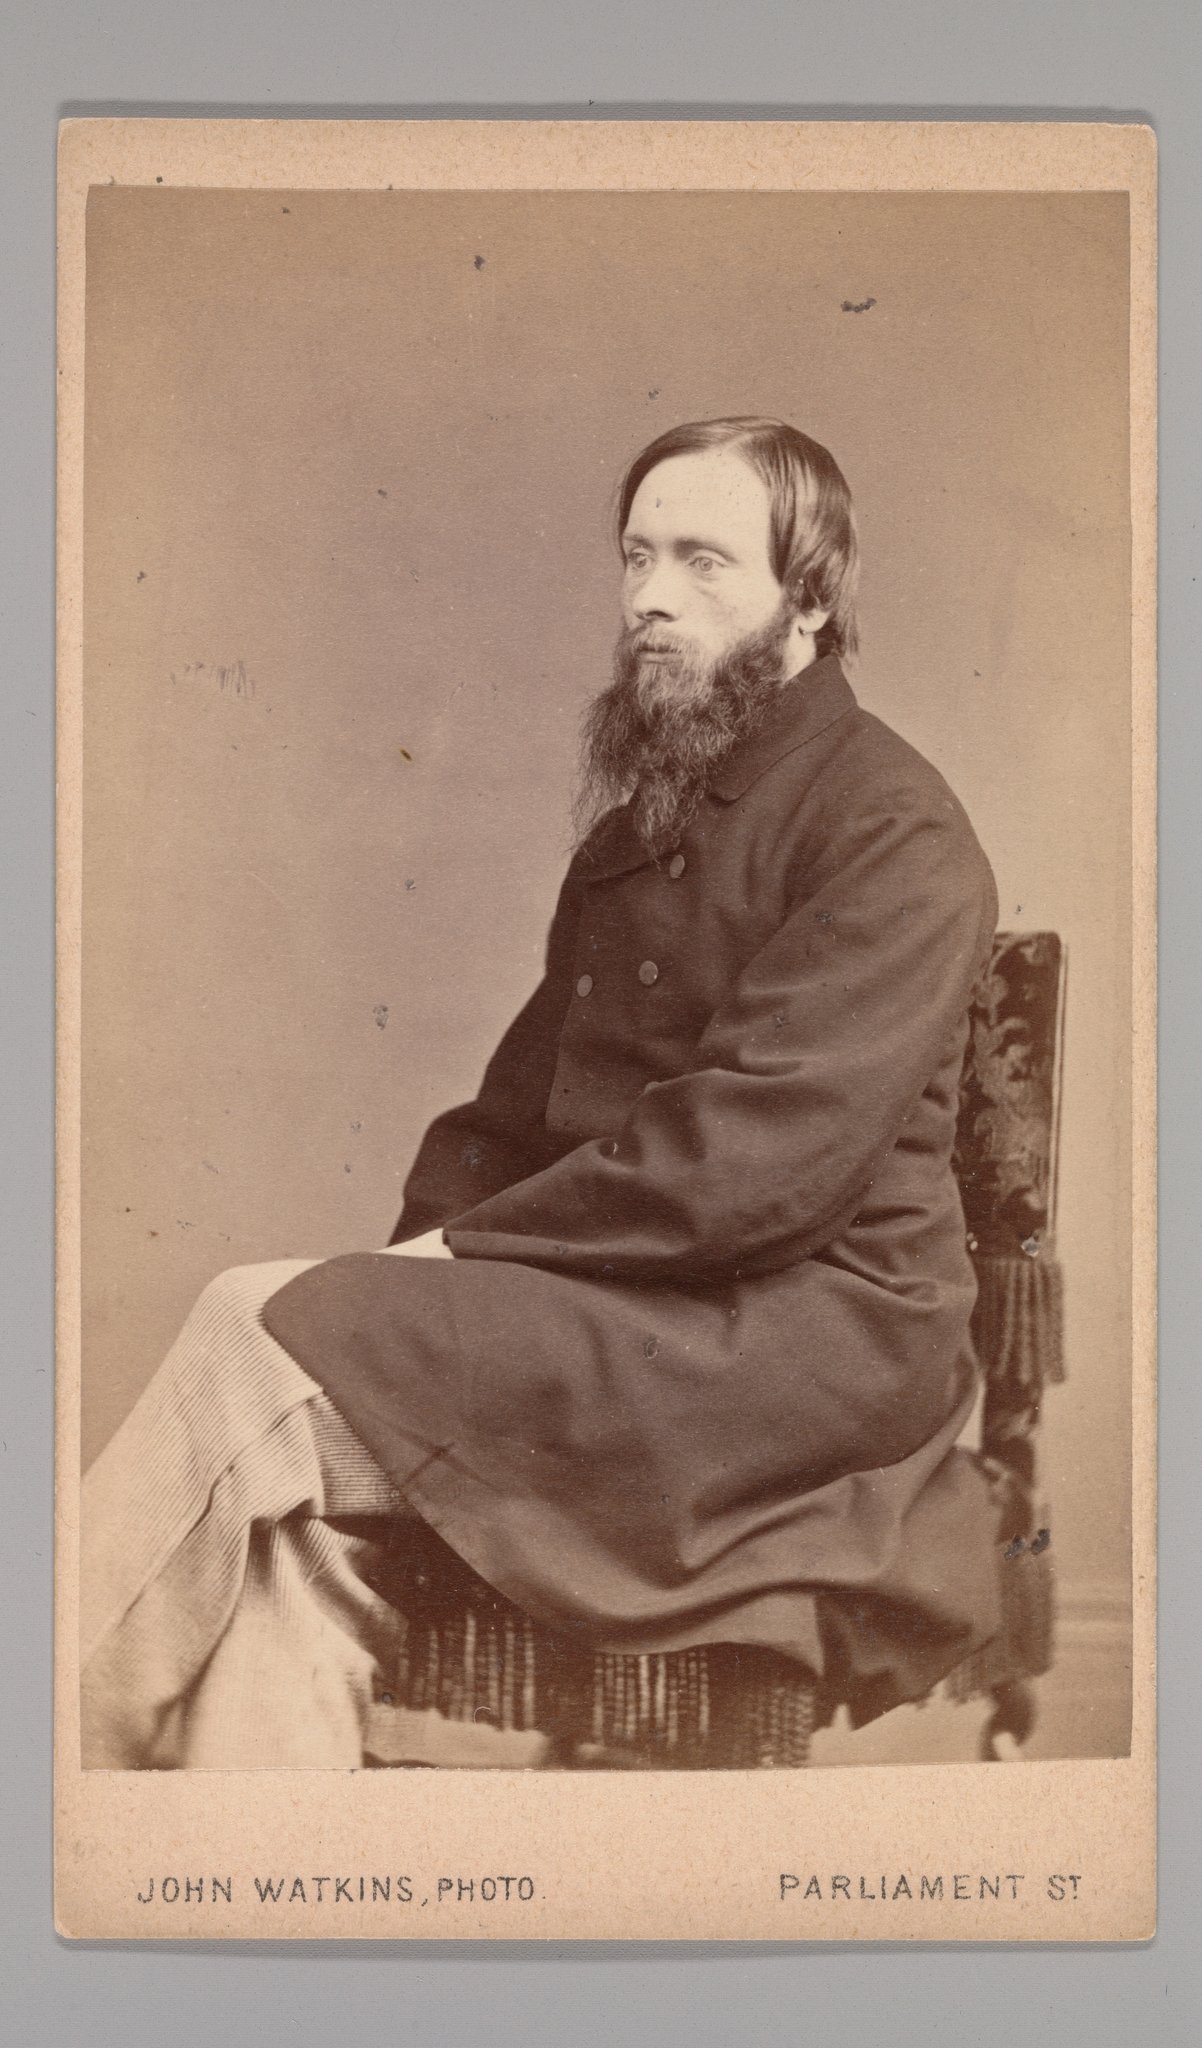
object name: carte de visite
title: [E.B. Jones]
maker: john and charles watkins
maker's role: photography studio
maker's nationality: british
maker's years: 1840-1875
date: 1860-1869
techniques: albumen silver print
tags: men,portraits